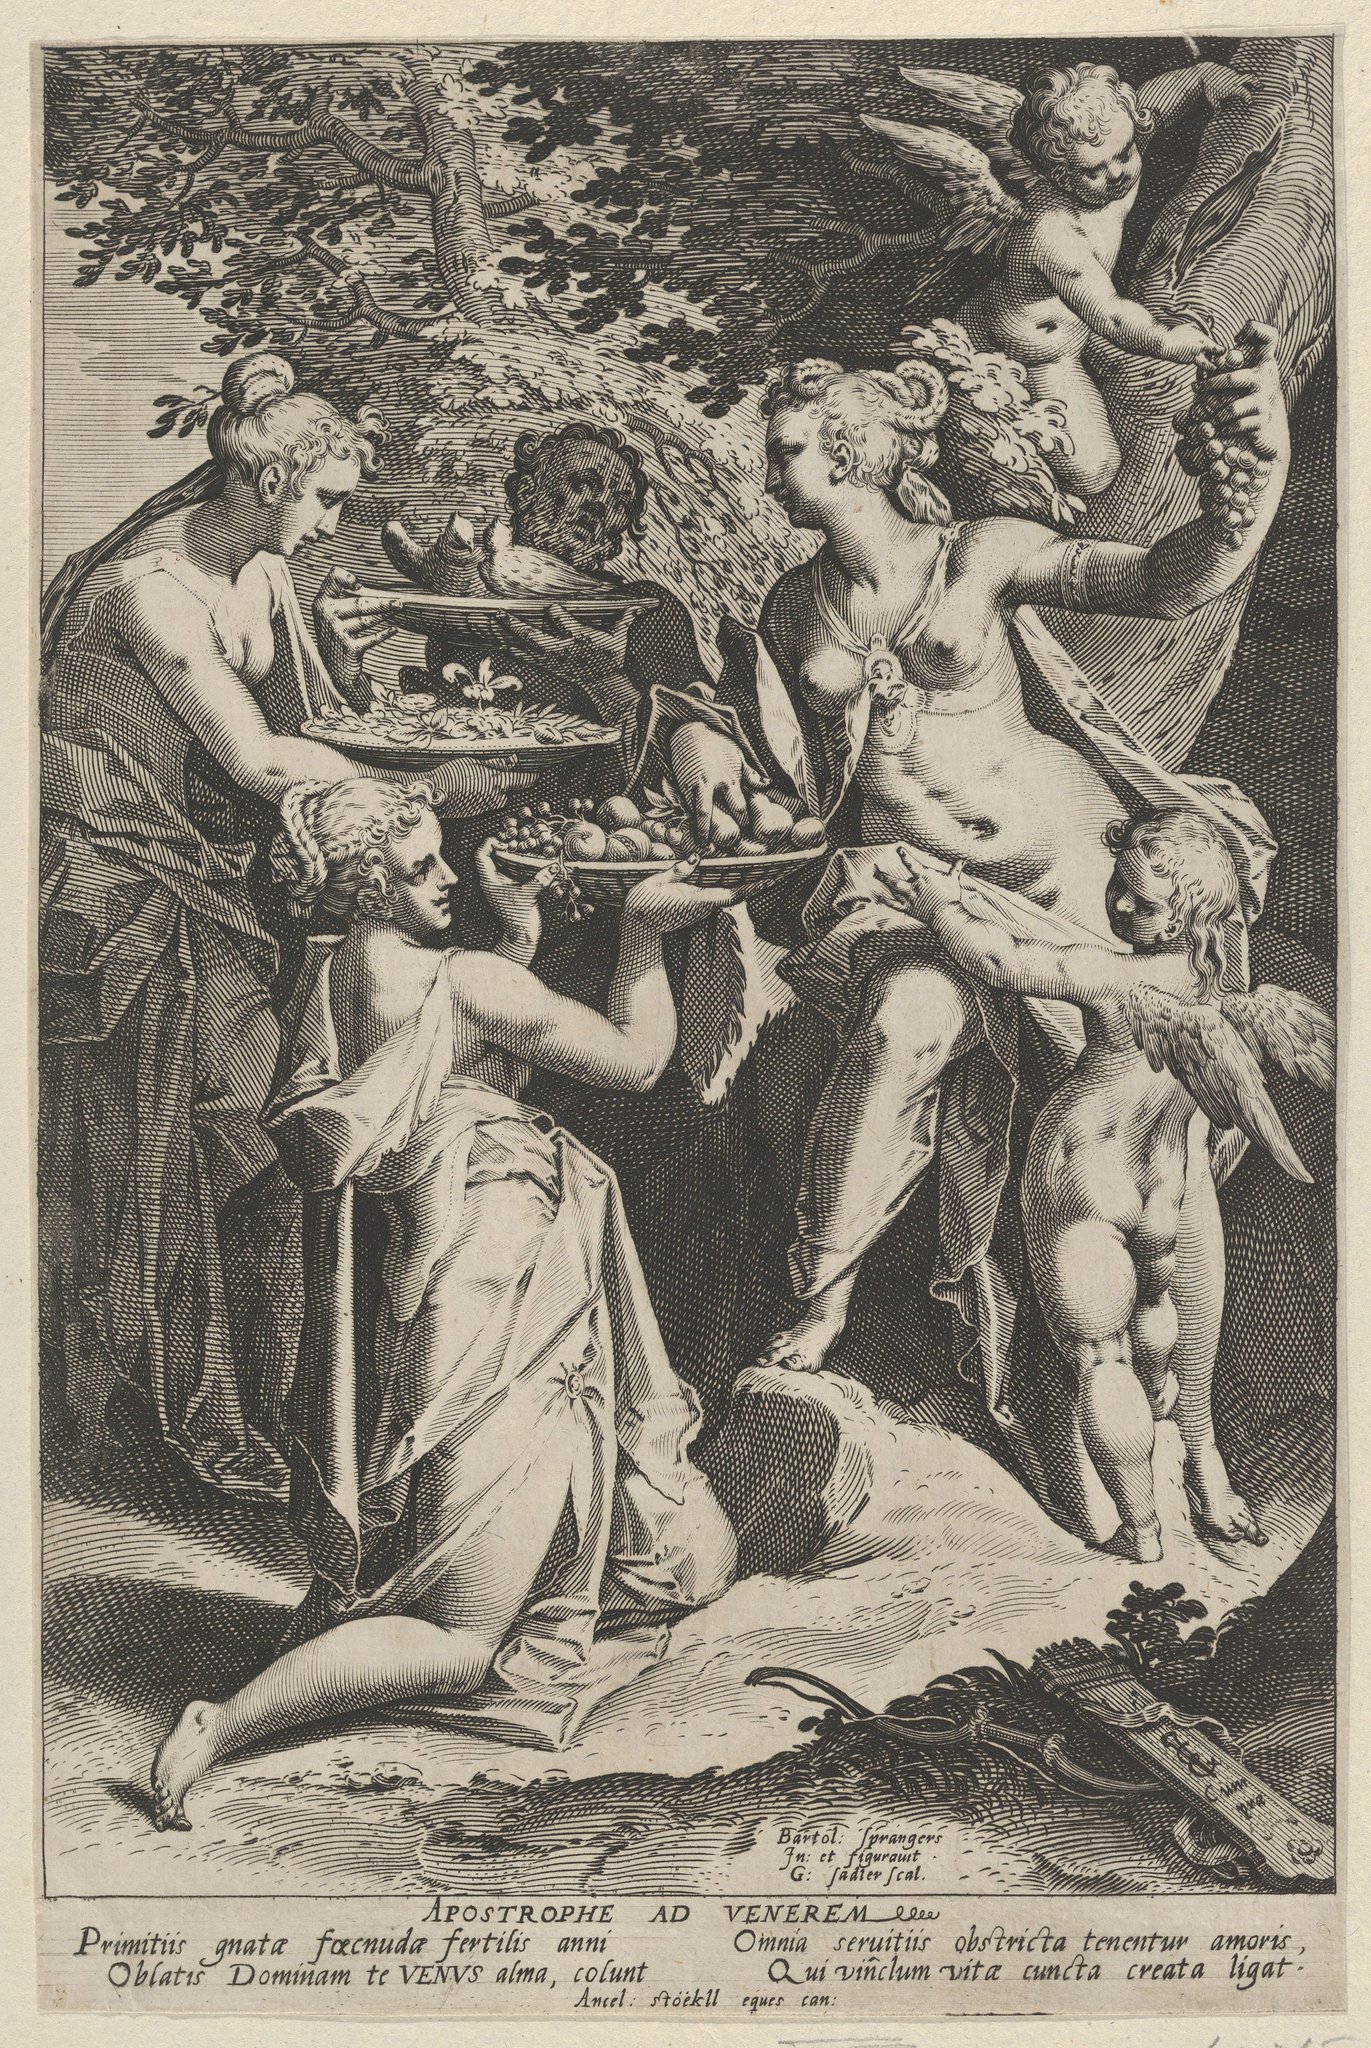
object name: print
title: Venus Receiving Gifts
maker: aegidius sadeler (ii)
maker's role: artist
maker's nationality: flemish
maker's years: 1568-1629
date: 1586-1601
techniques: engraving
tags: fruit,venus